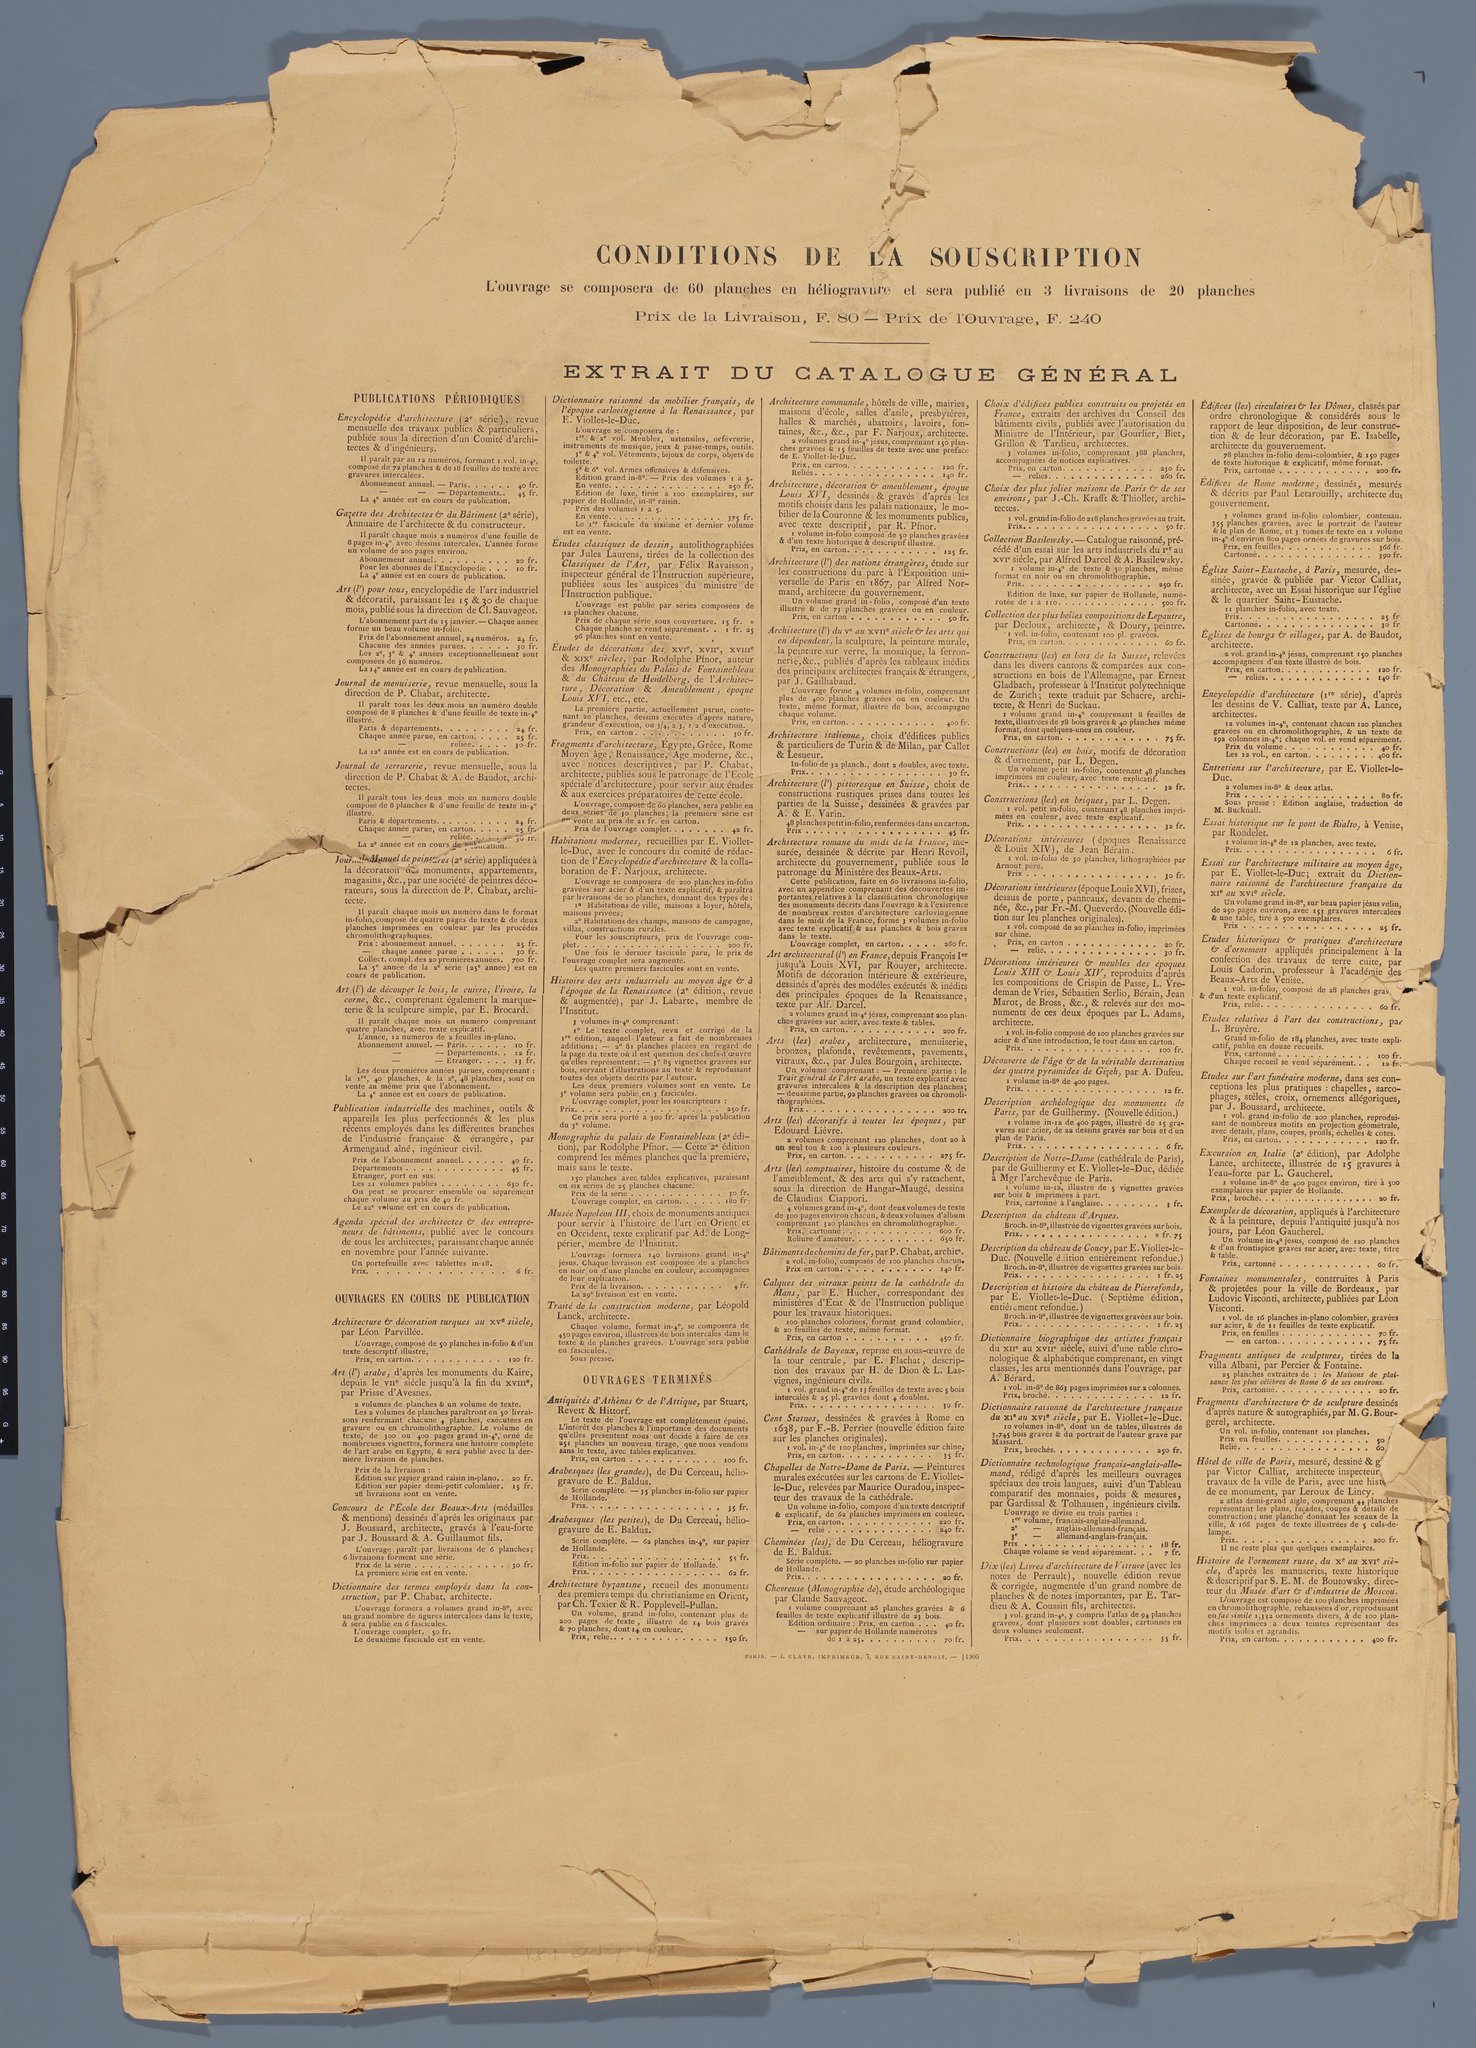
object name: page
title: Les monuments principaux de la France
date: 1875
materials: paper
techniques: photoaquatint, printing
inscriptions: inscription: ‘Eglise Saint-Trophime a Arles (...) Arc de Triomphe du Carrousel, Paris.’